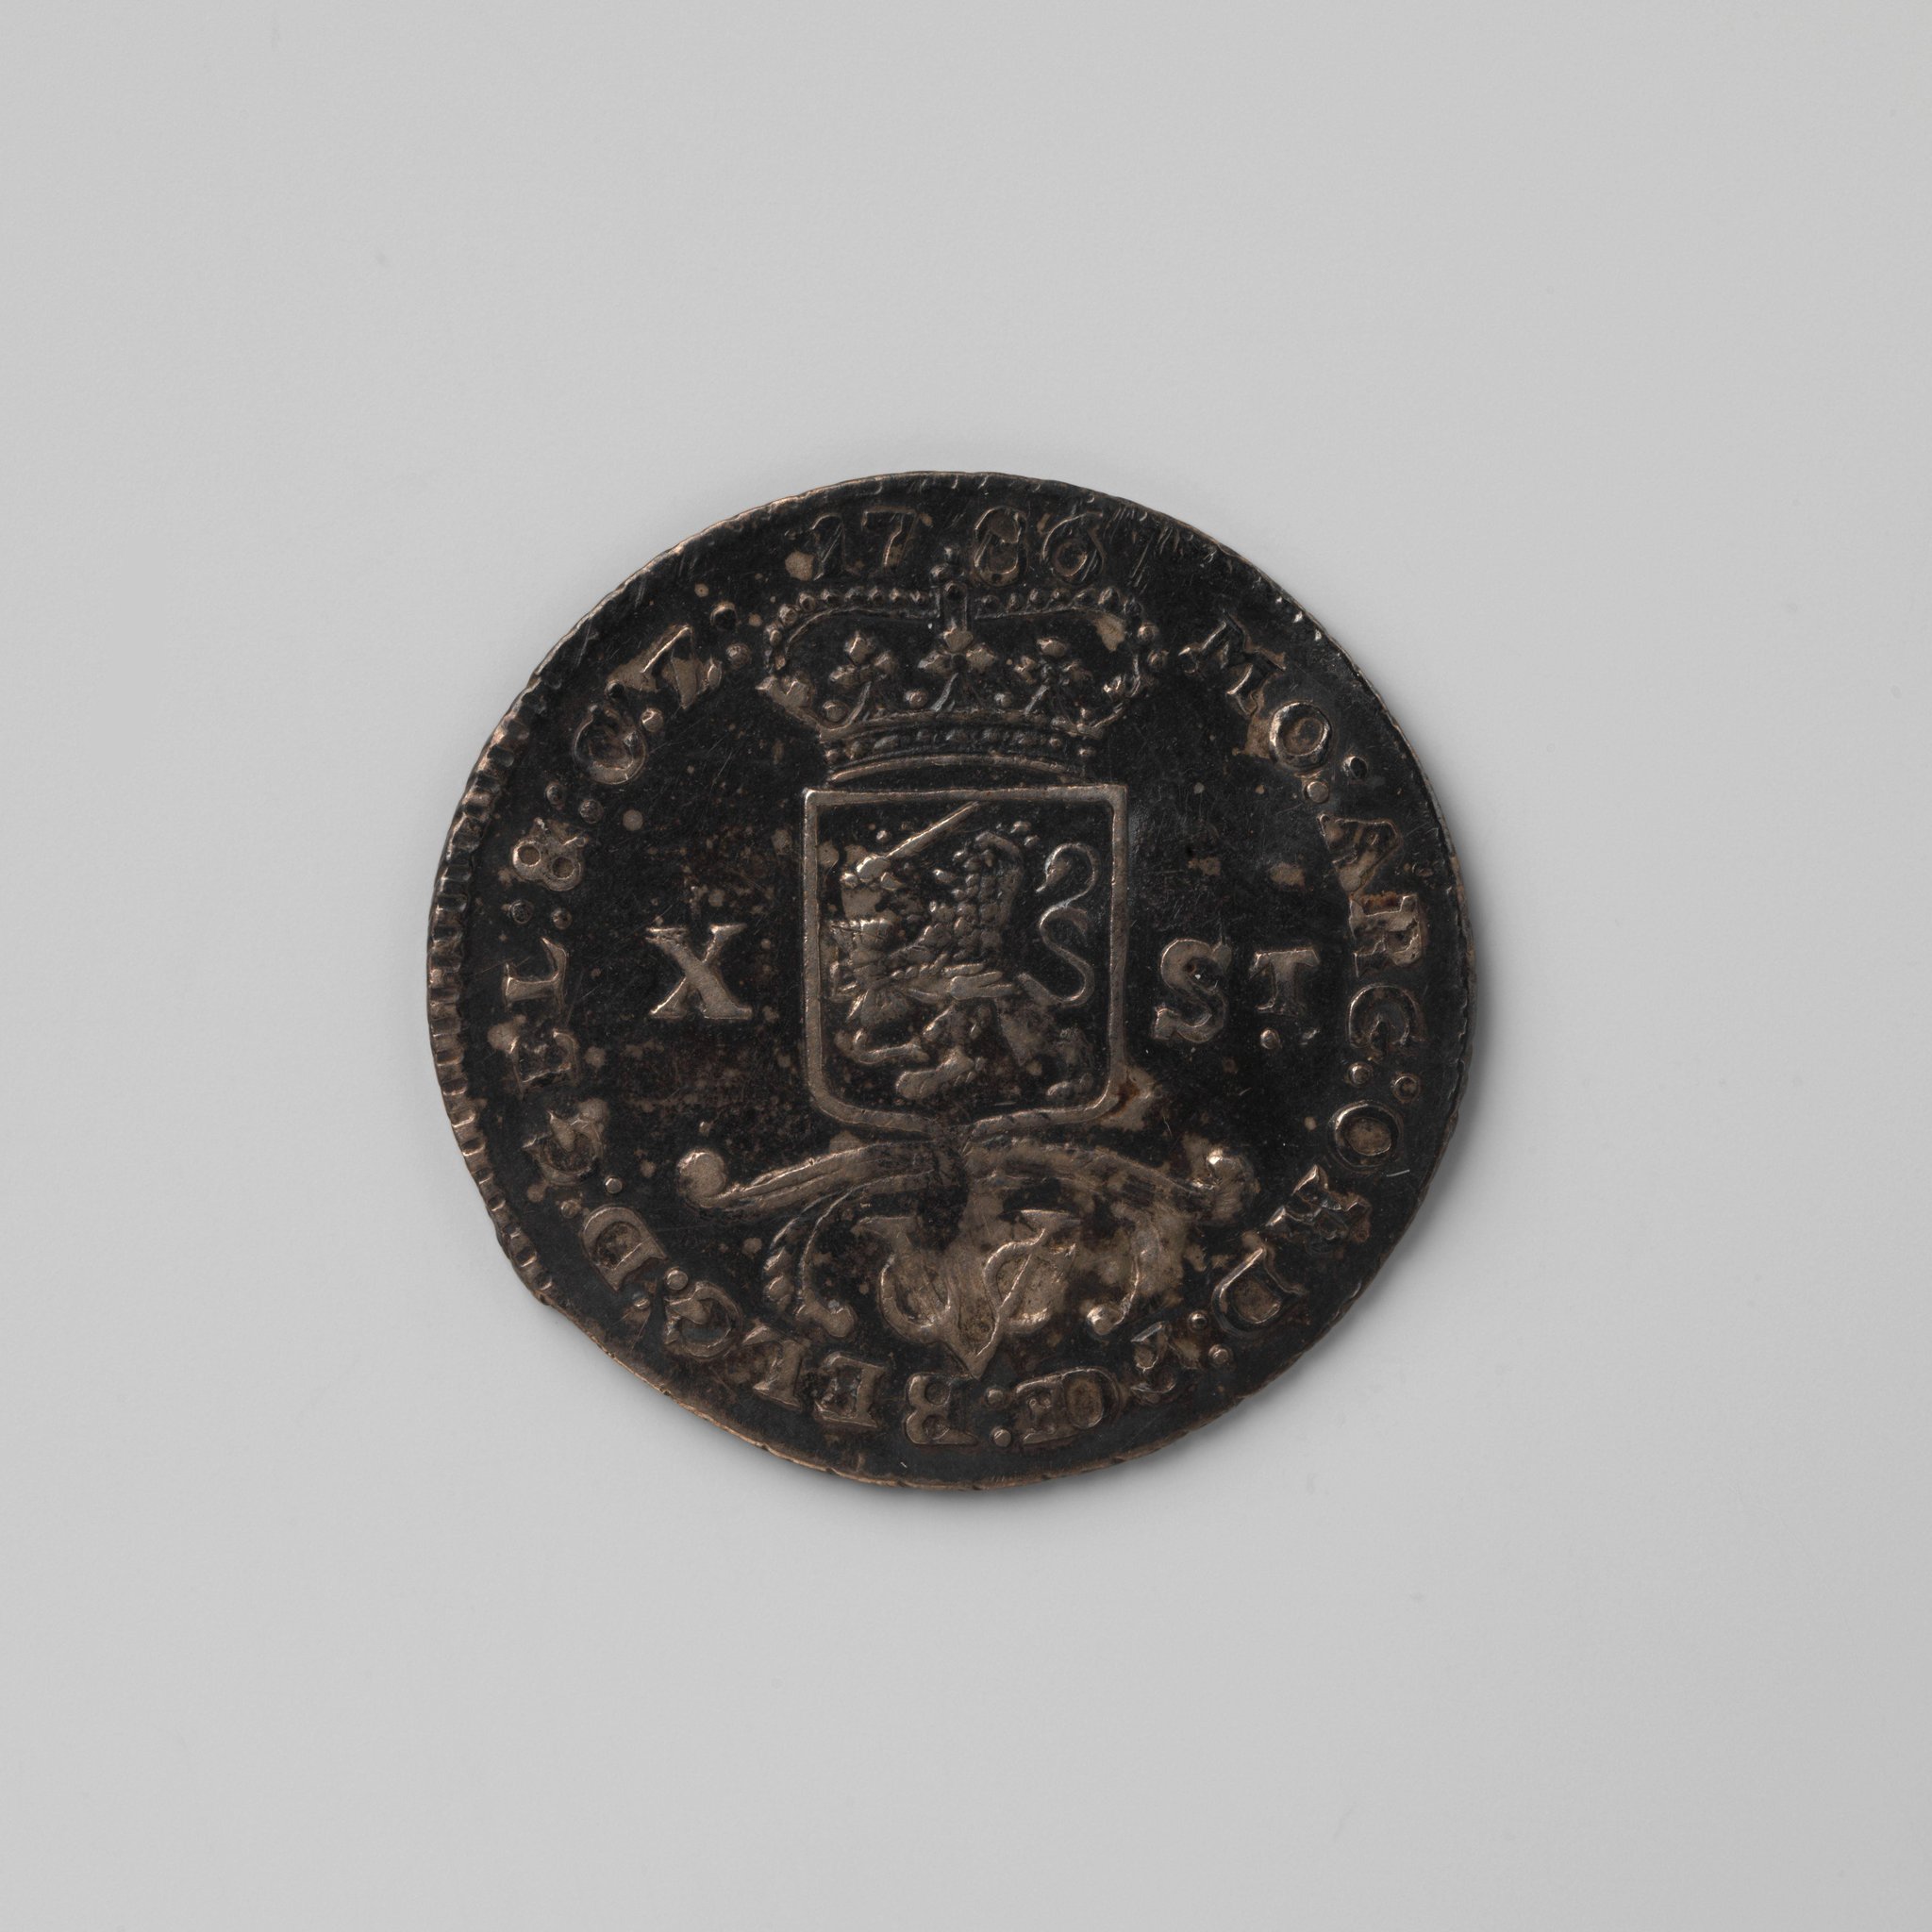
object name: coin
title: ½ gulden van de VOC uit Gelderland, 1786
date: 1786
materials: silver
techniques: striking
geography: harderwijk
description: Zilveren munt. Voorzijde: tussen waarde-aanduiding X St. gekroond generaliteitswapenschild, waaronder cartouche, waarin monogram van de VOC. Jaartal boven kroon. Keerzijde: Nederlandse maagd met speer, waarop vrijheidshoed, leunend op een bijbel op een altaar. Kabelrand.